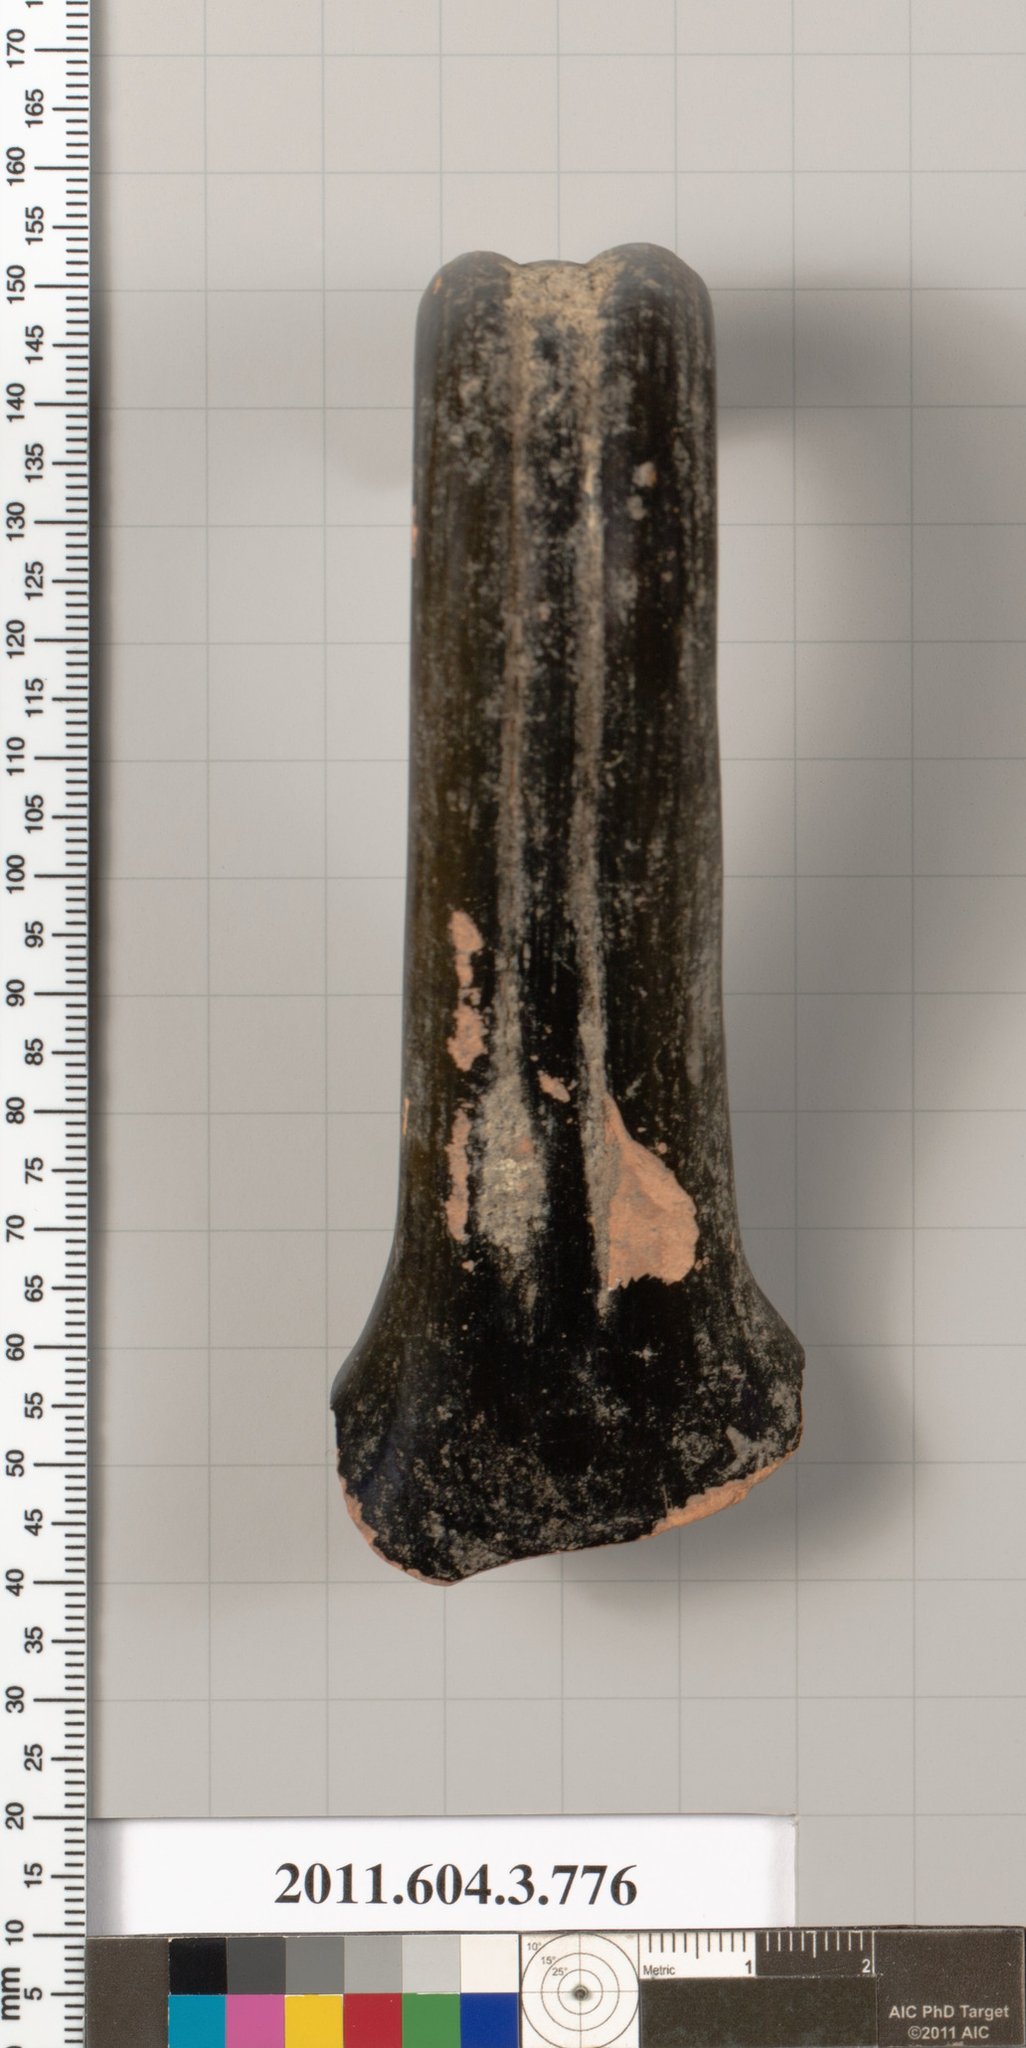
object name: oinochoe fragment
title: Terracotta fragment of an oinochoe (jug)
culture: greek, attic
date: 534-468 BCE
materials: terracotta